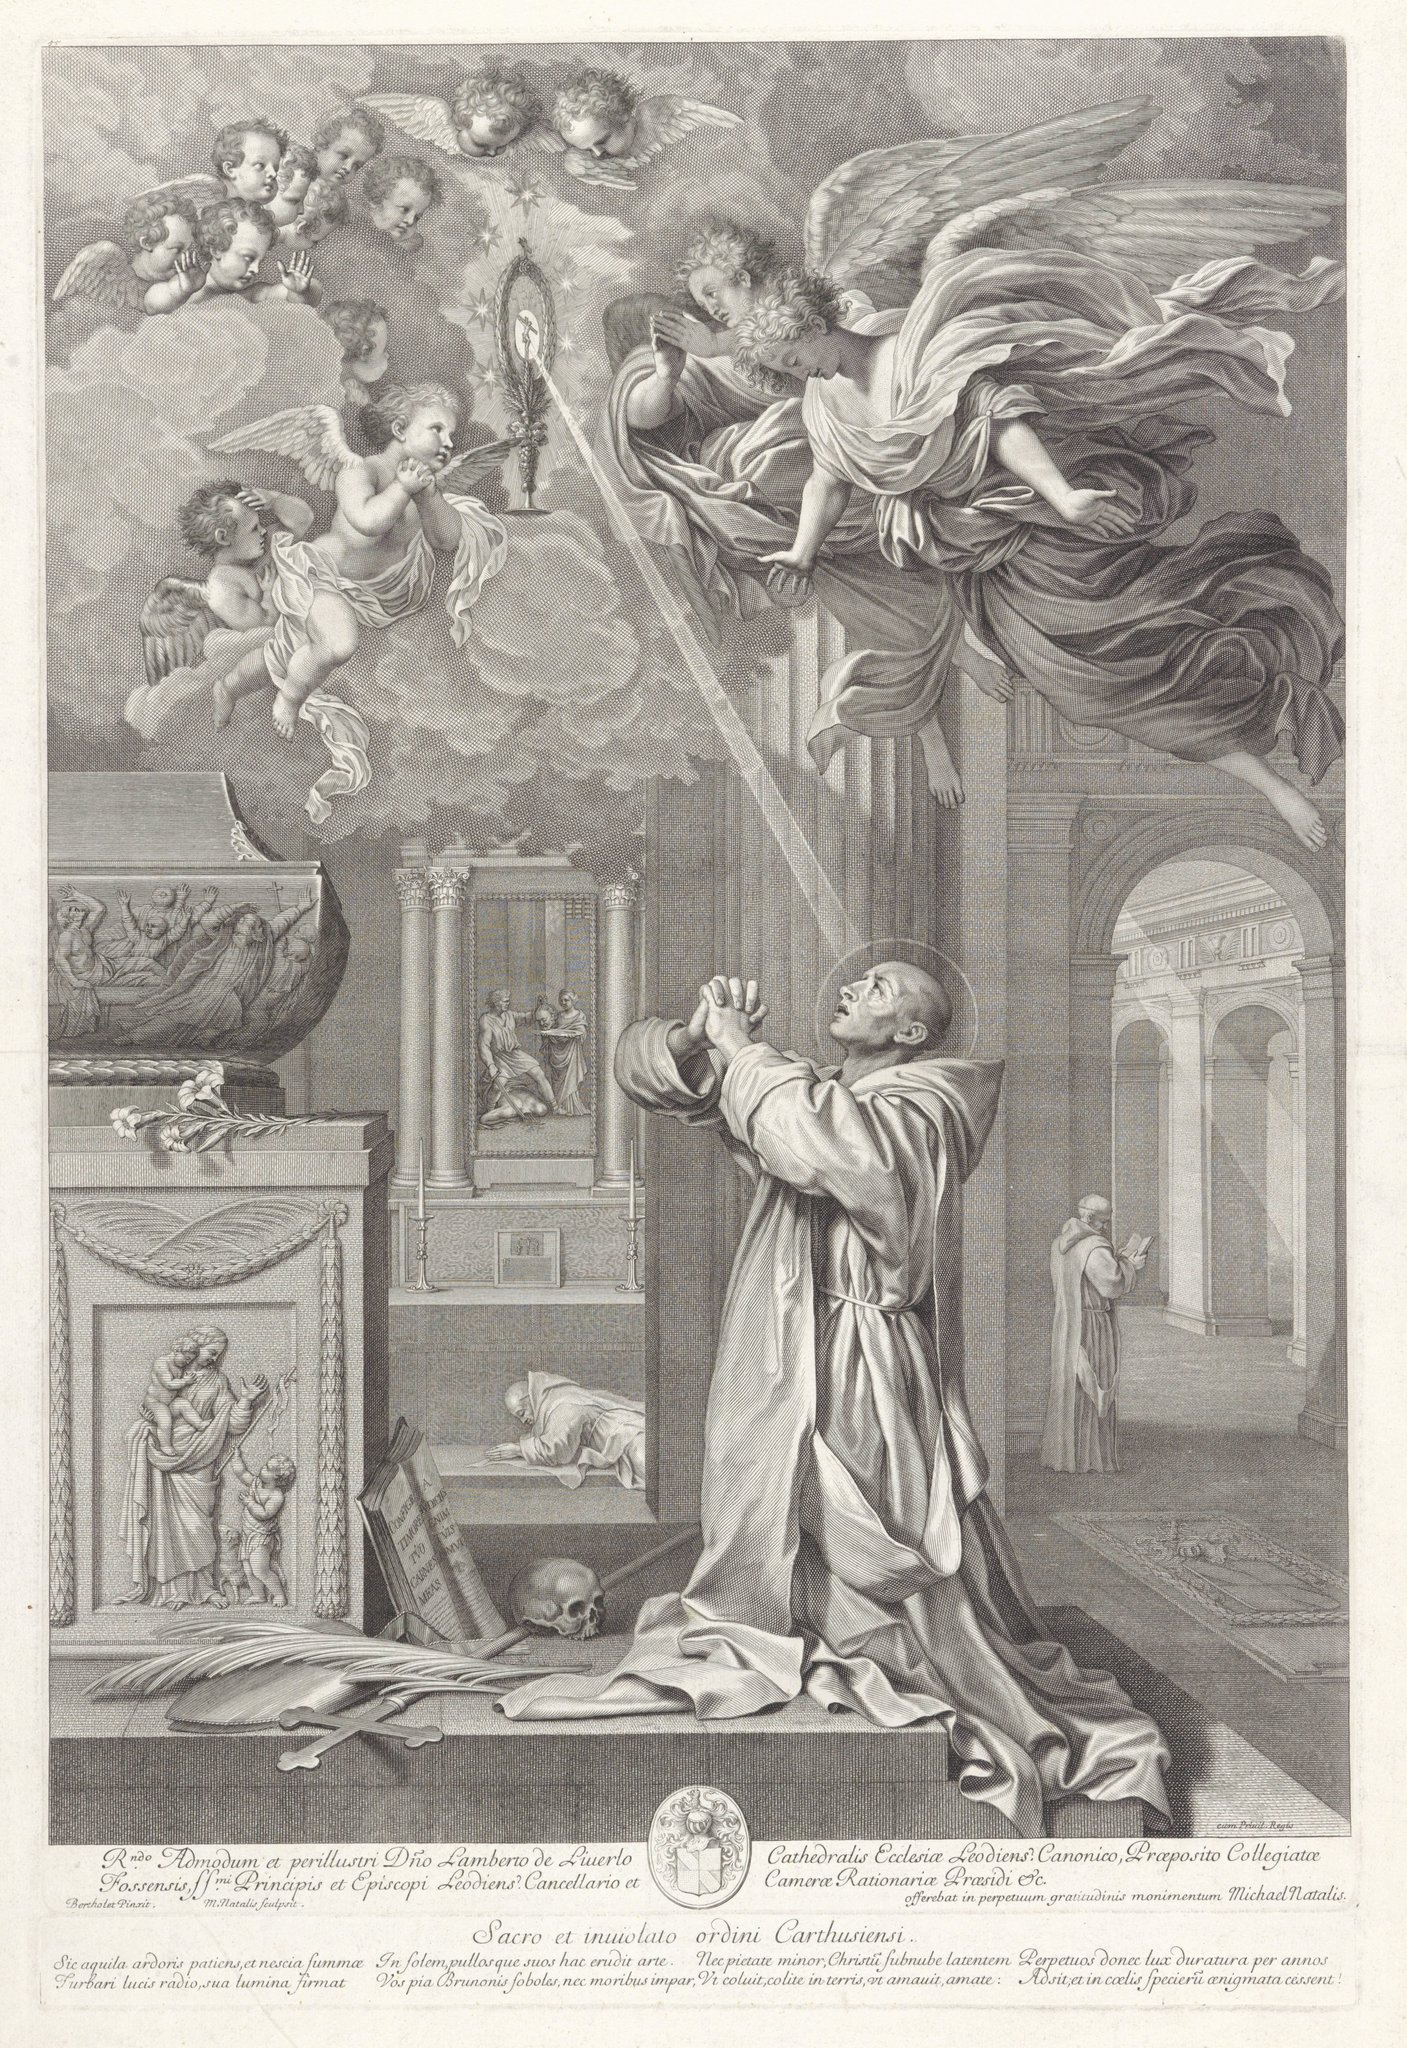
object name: print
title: De heilige Bruno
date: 1620-1668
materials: paper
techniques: engraving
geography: liège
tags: the founder of the order of the carthusians, bruno; possible attributes: cross, finger at lips, lily, mitre at his feet, olive-branch, ray of light, skull, (seven) star(s), book - mm - book open, altar with altar-piece, the beheading of john the baptist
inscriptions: collector's mark: Lugt 240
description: De heilige Bruno, stichter van de orde van de kartuizers, knielt voor een verschijning van een crucifix in de hemel. De crucifix is gevat in een met bladeren versierde monstrans en wordt omringd door zeven sterren. Engelen en putti aanbidden op de wolken het kruis. Bruno zit geknield voor een tombe en voor hem liggen een mijter en een staf, palmbladeren en een schedel. Op de achtergrond knielt Bruno voor een altaar met een afbeelding van de onthoofding van Johannes de Doper. Rechtsachter leest Bruno staande uit een boek. Onderaan in de marge de opdracht in het Latijn.